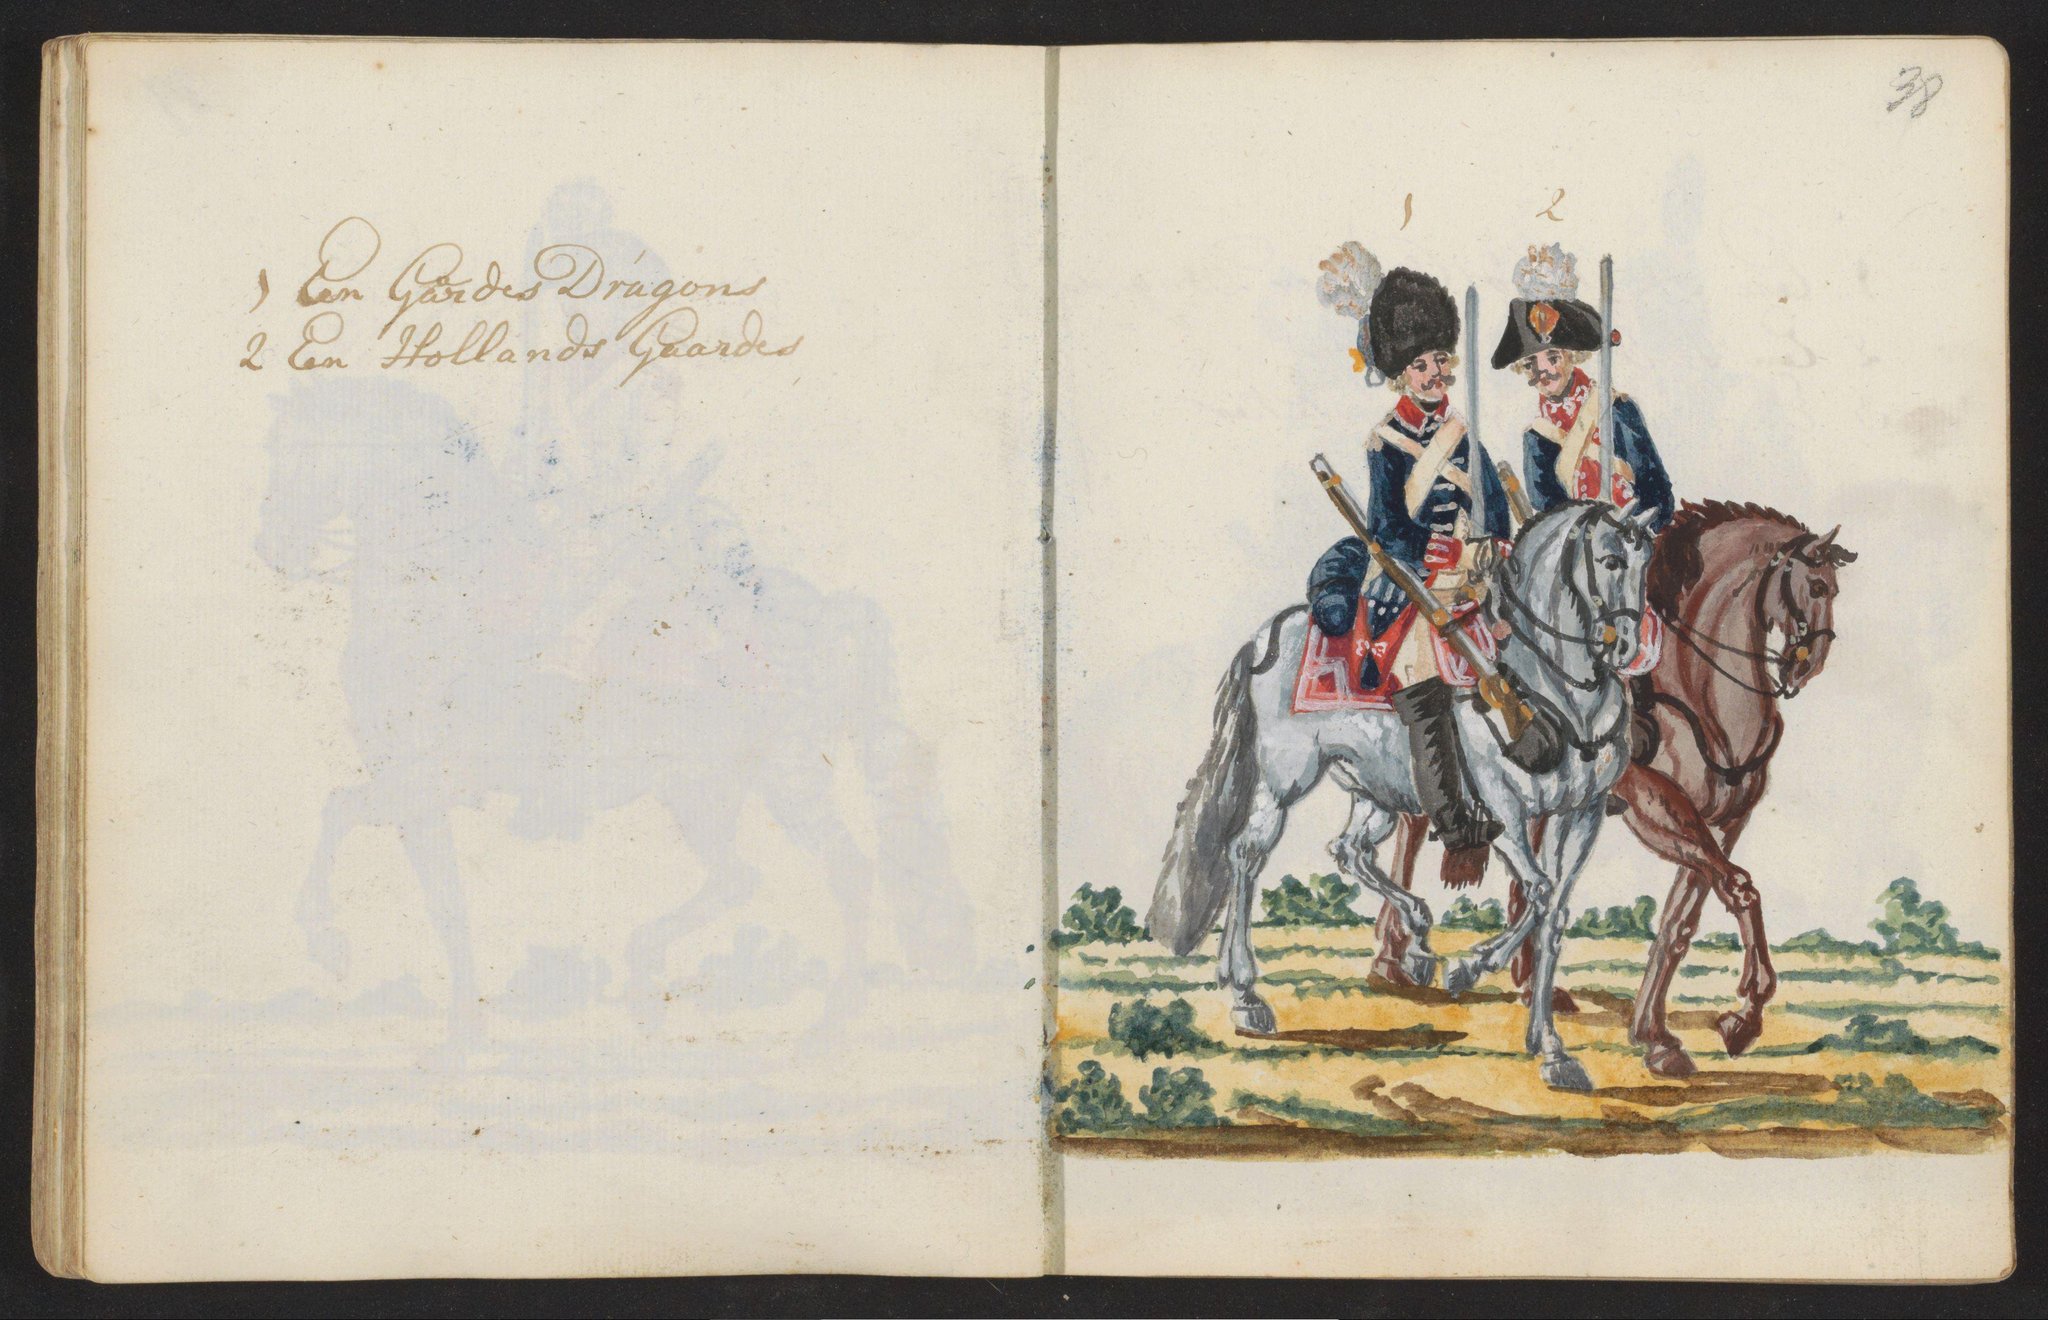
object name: drawing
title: Uniformen van Gardes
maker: s.g. casten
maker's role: draughtsman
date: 1795-1796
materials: paper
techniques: writing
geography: amsterdam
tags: (military) uniforms (+ cavalry, horsemen), patriots (1780-1795)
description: Uniformen van de Gardes Dragons en de Hollandse Gardes, 1788. Onderdeel van het derde hoofdstuk over de nieuwe uniformen in de periode na het herstel van de prins van Oranje en de komst van de Pruisische troepen in Holland in 1787. In het schetsboek met gekleurde tekeningen van de uniformen van militairen en leden van de schutterij uit de periode 1770 tot 1795-1796.